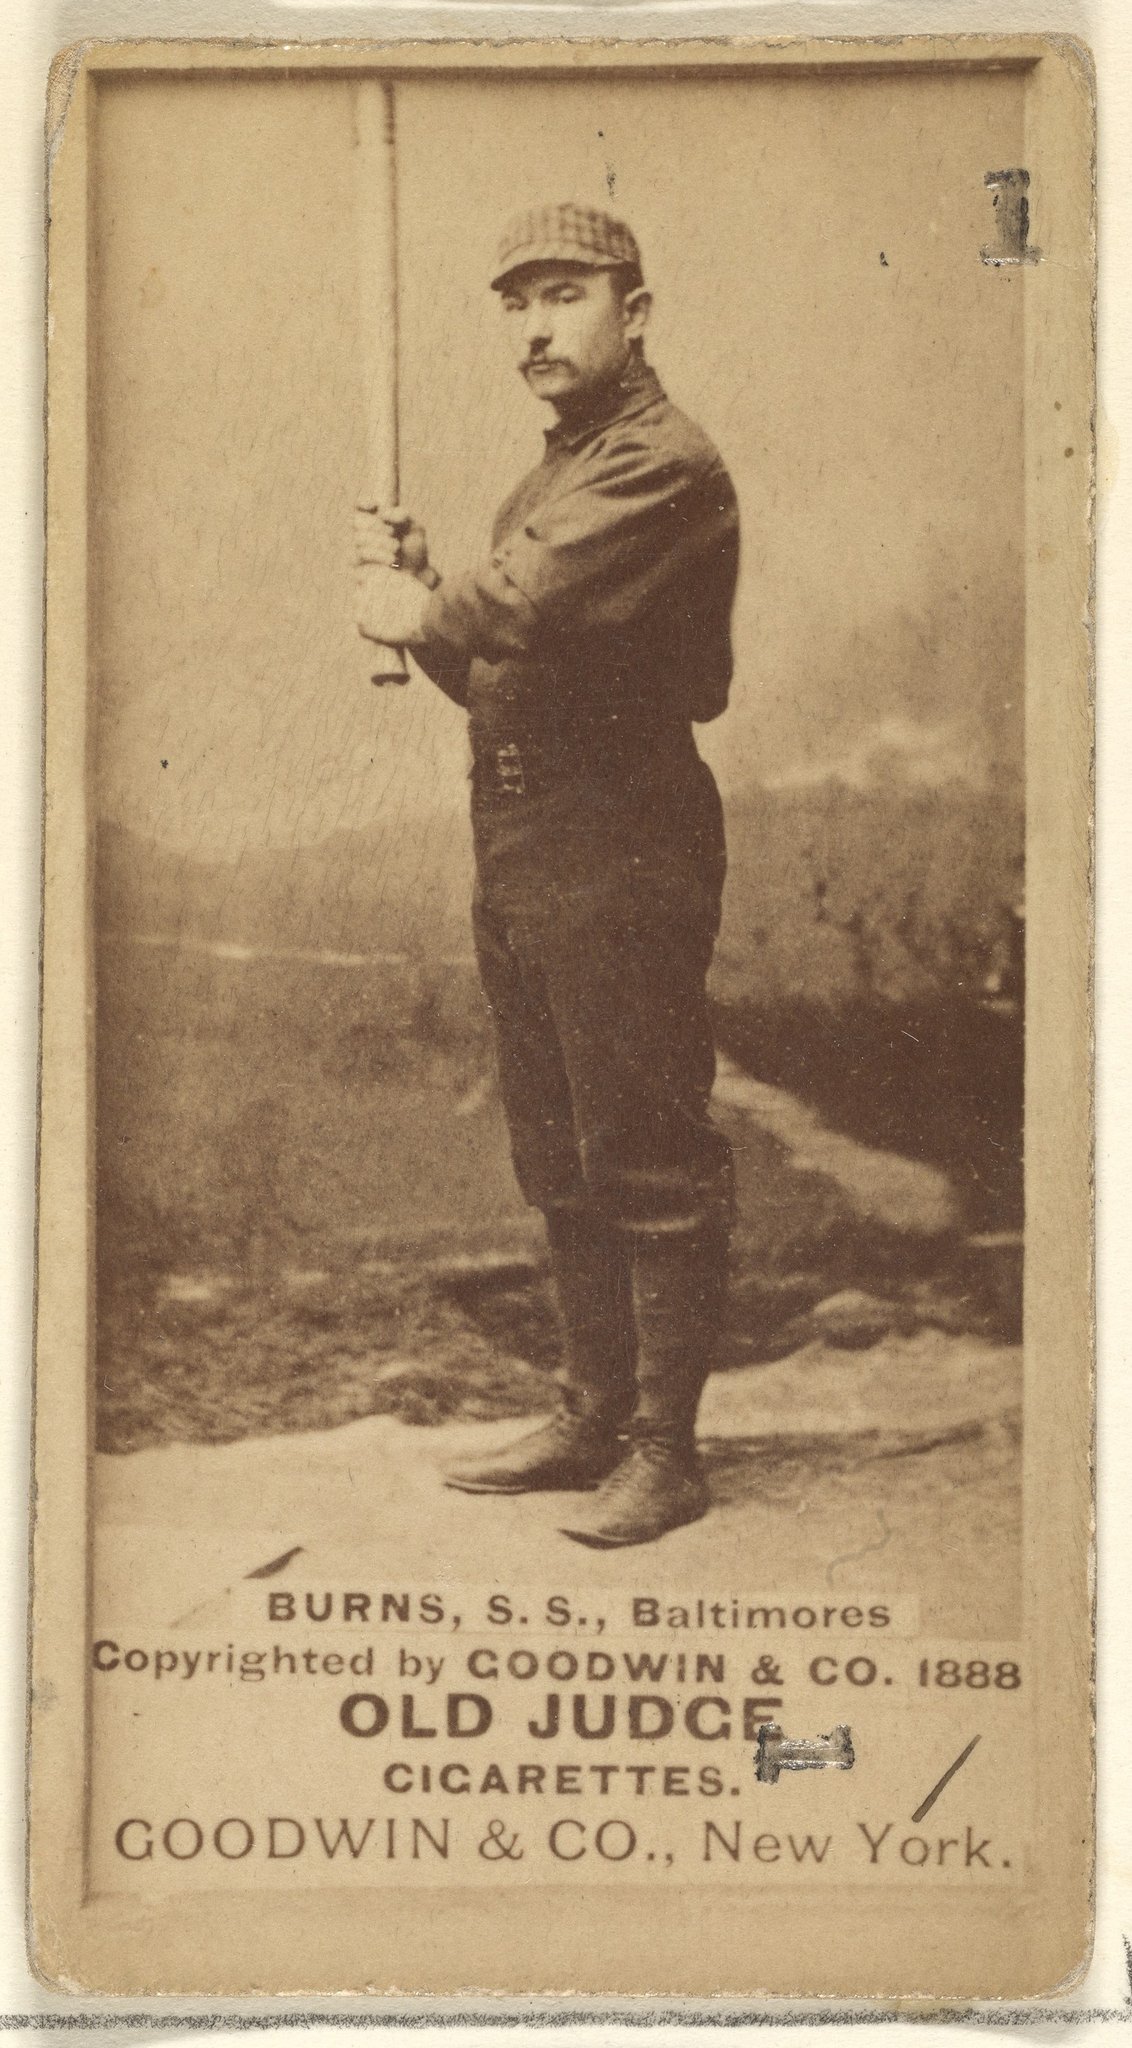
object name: baseball card, photograph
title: Burns, Shortstop, Baltimore Orioles, from the Old Judge series (N172) for Old Judge Cigarettes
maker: goodwin & company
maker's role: publisher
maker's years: 1850-1950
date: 1888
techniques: albumen silver print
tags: men,portraits,baseball,athletes